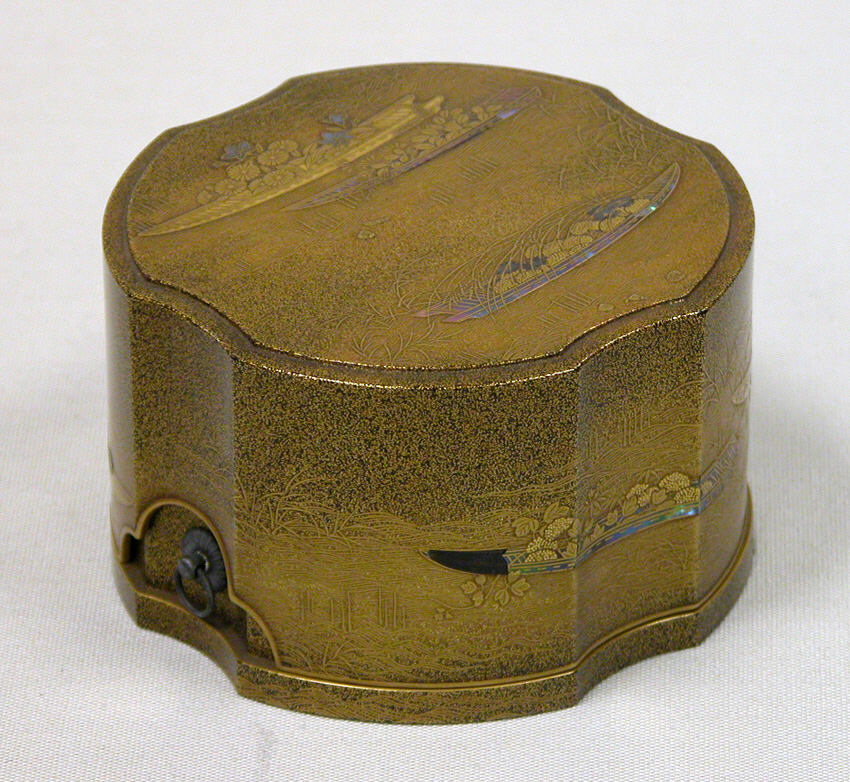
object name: box with cover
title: Set of Two Boxes with Cover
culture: japanese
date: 1701-1800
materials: gold, lacquer, mother of pearl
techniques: inlay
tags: flowers,boats